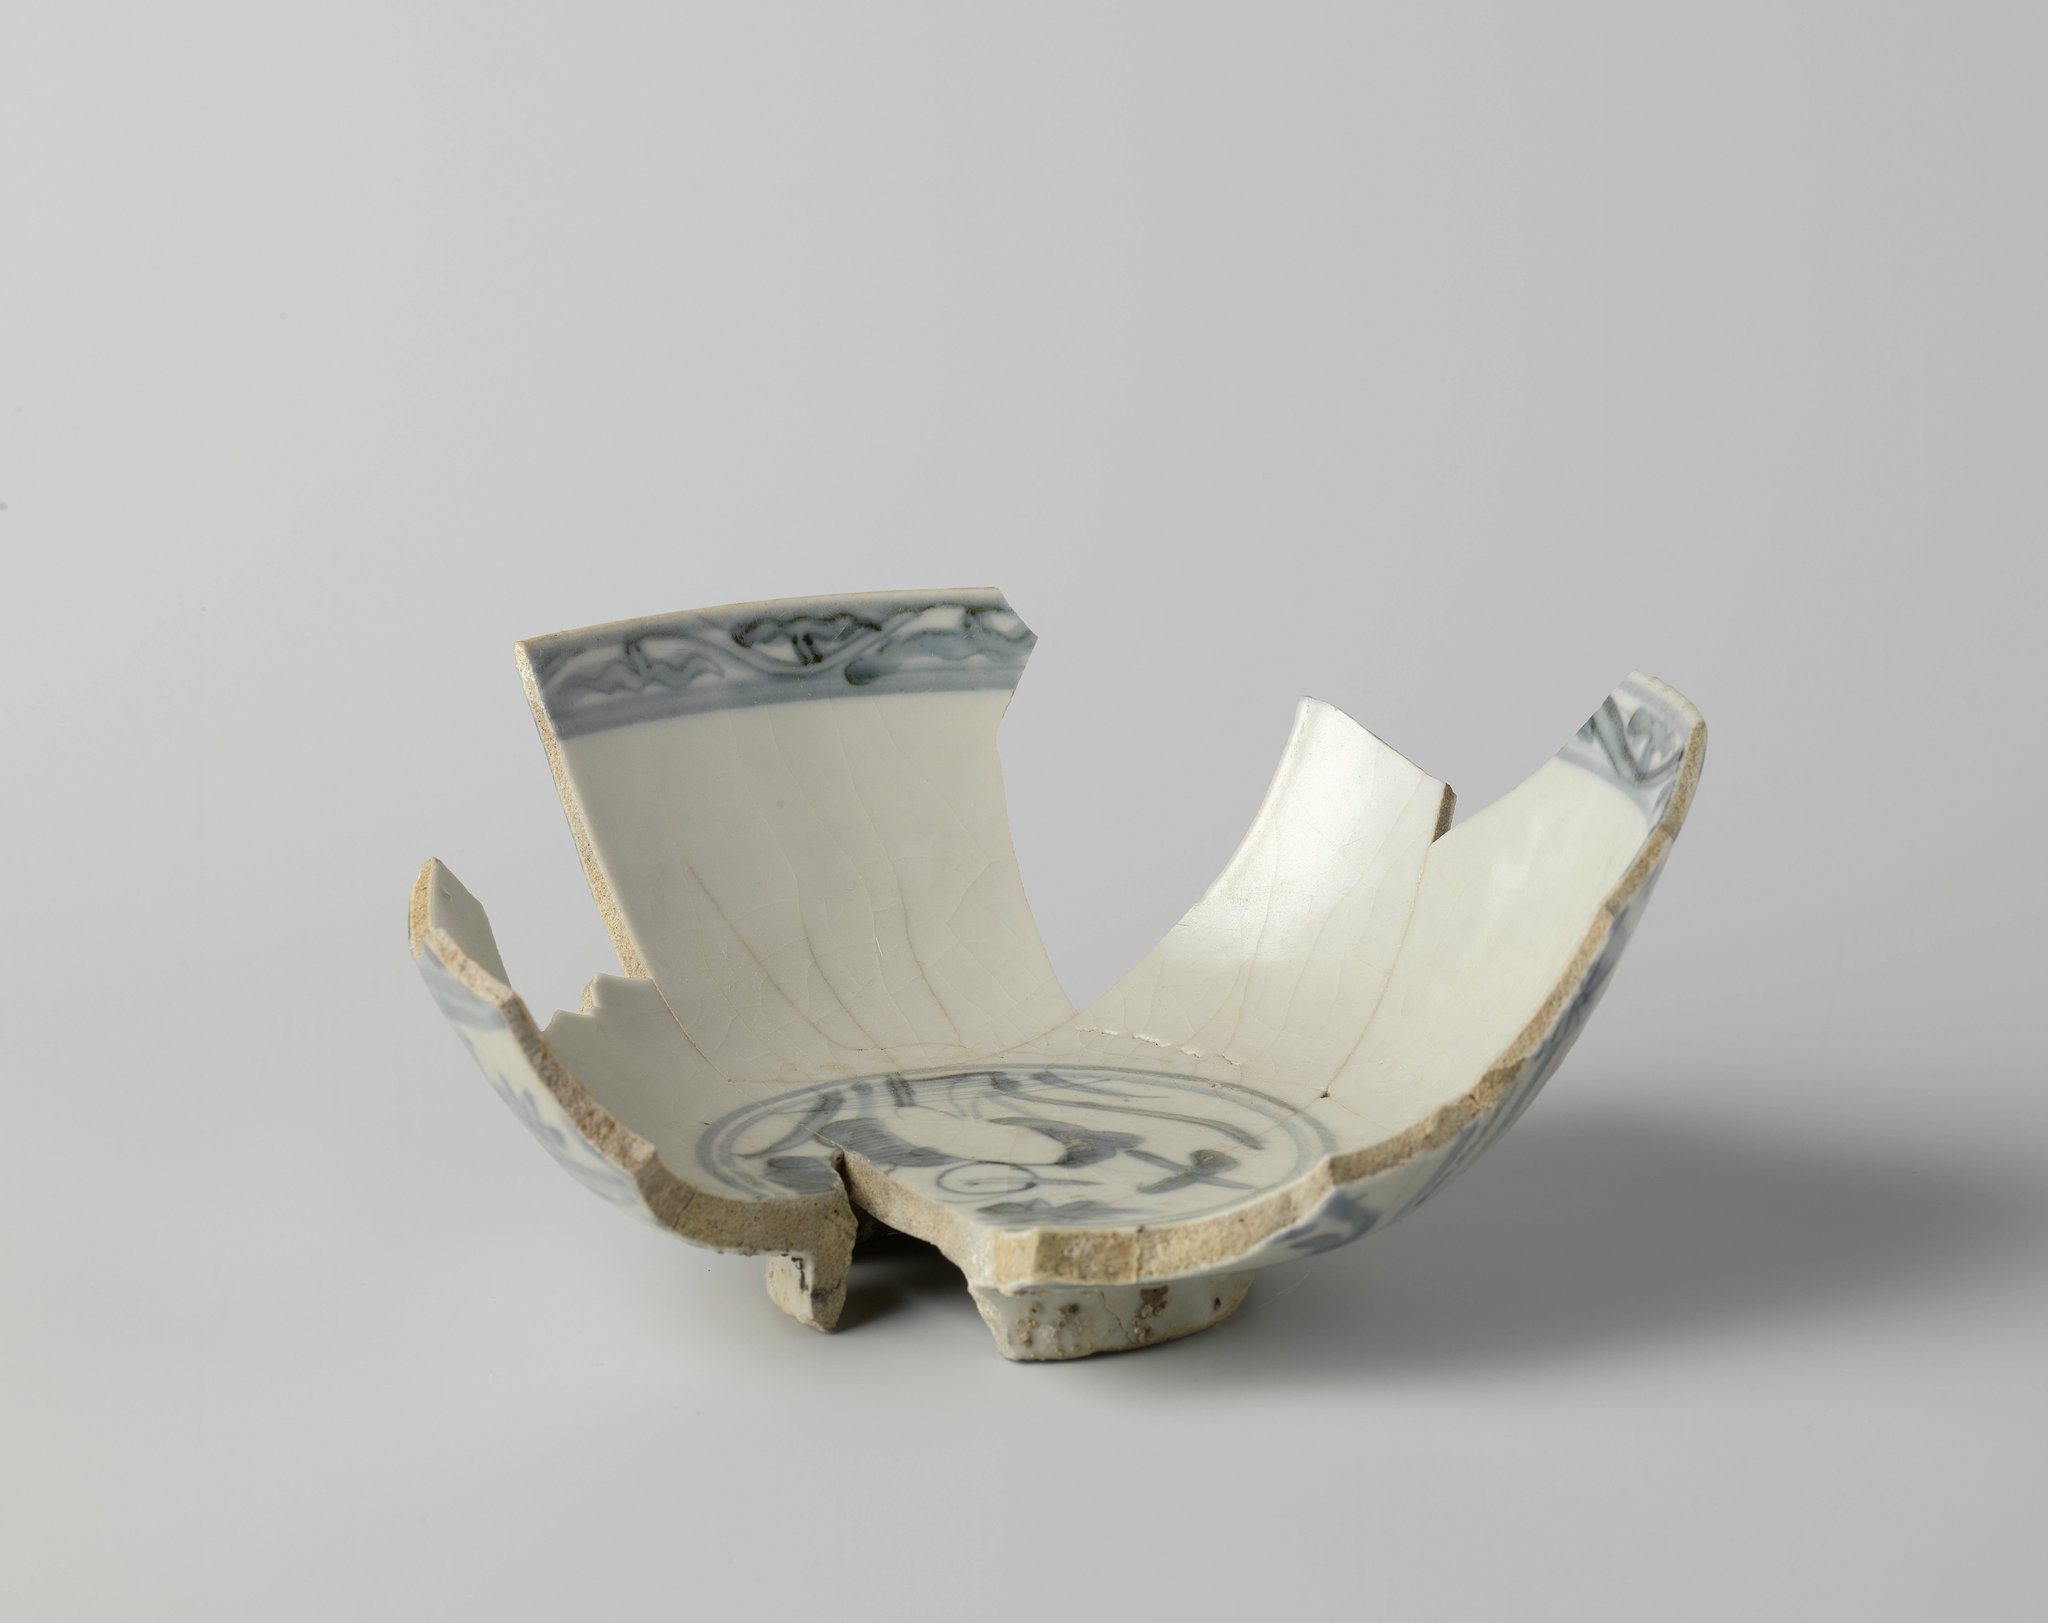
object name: sherd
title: Fragment kom uit V.O.C.-schip de 'Witte Leeuw'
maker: Anonymous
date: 1613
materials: porcelain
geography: shantou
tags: verenigde oostindische compagnie, sint-helena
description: A bowl. In the centre there is a standing crane among grass. Around the lip-rim a sketchy design of leaves. On the outside a pond landscape, 4 groups of ducks are drawn, one under the other, with a large lotus leaf and pond weeds in between.